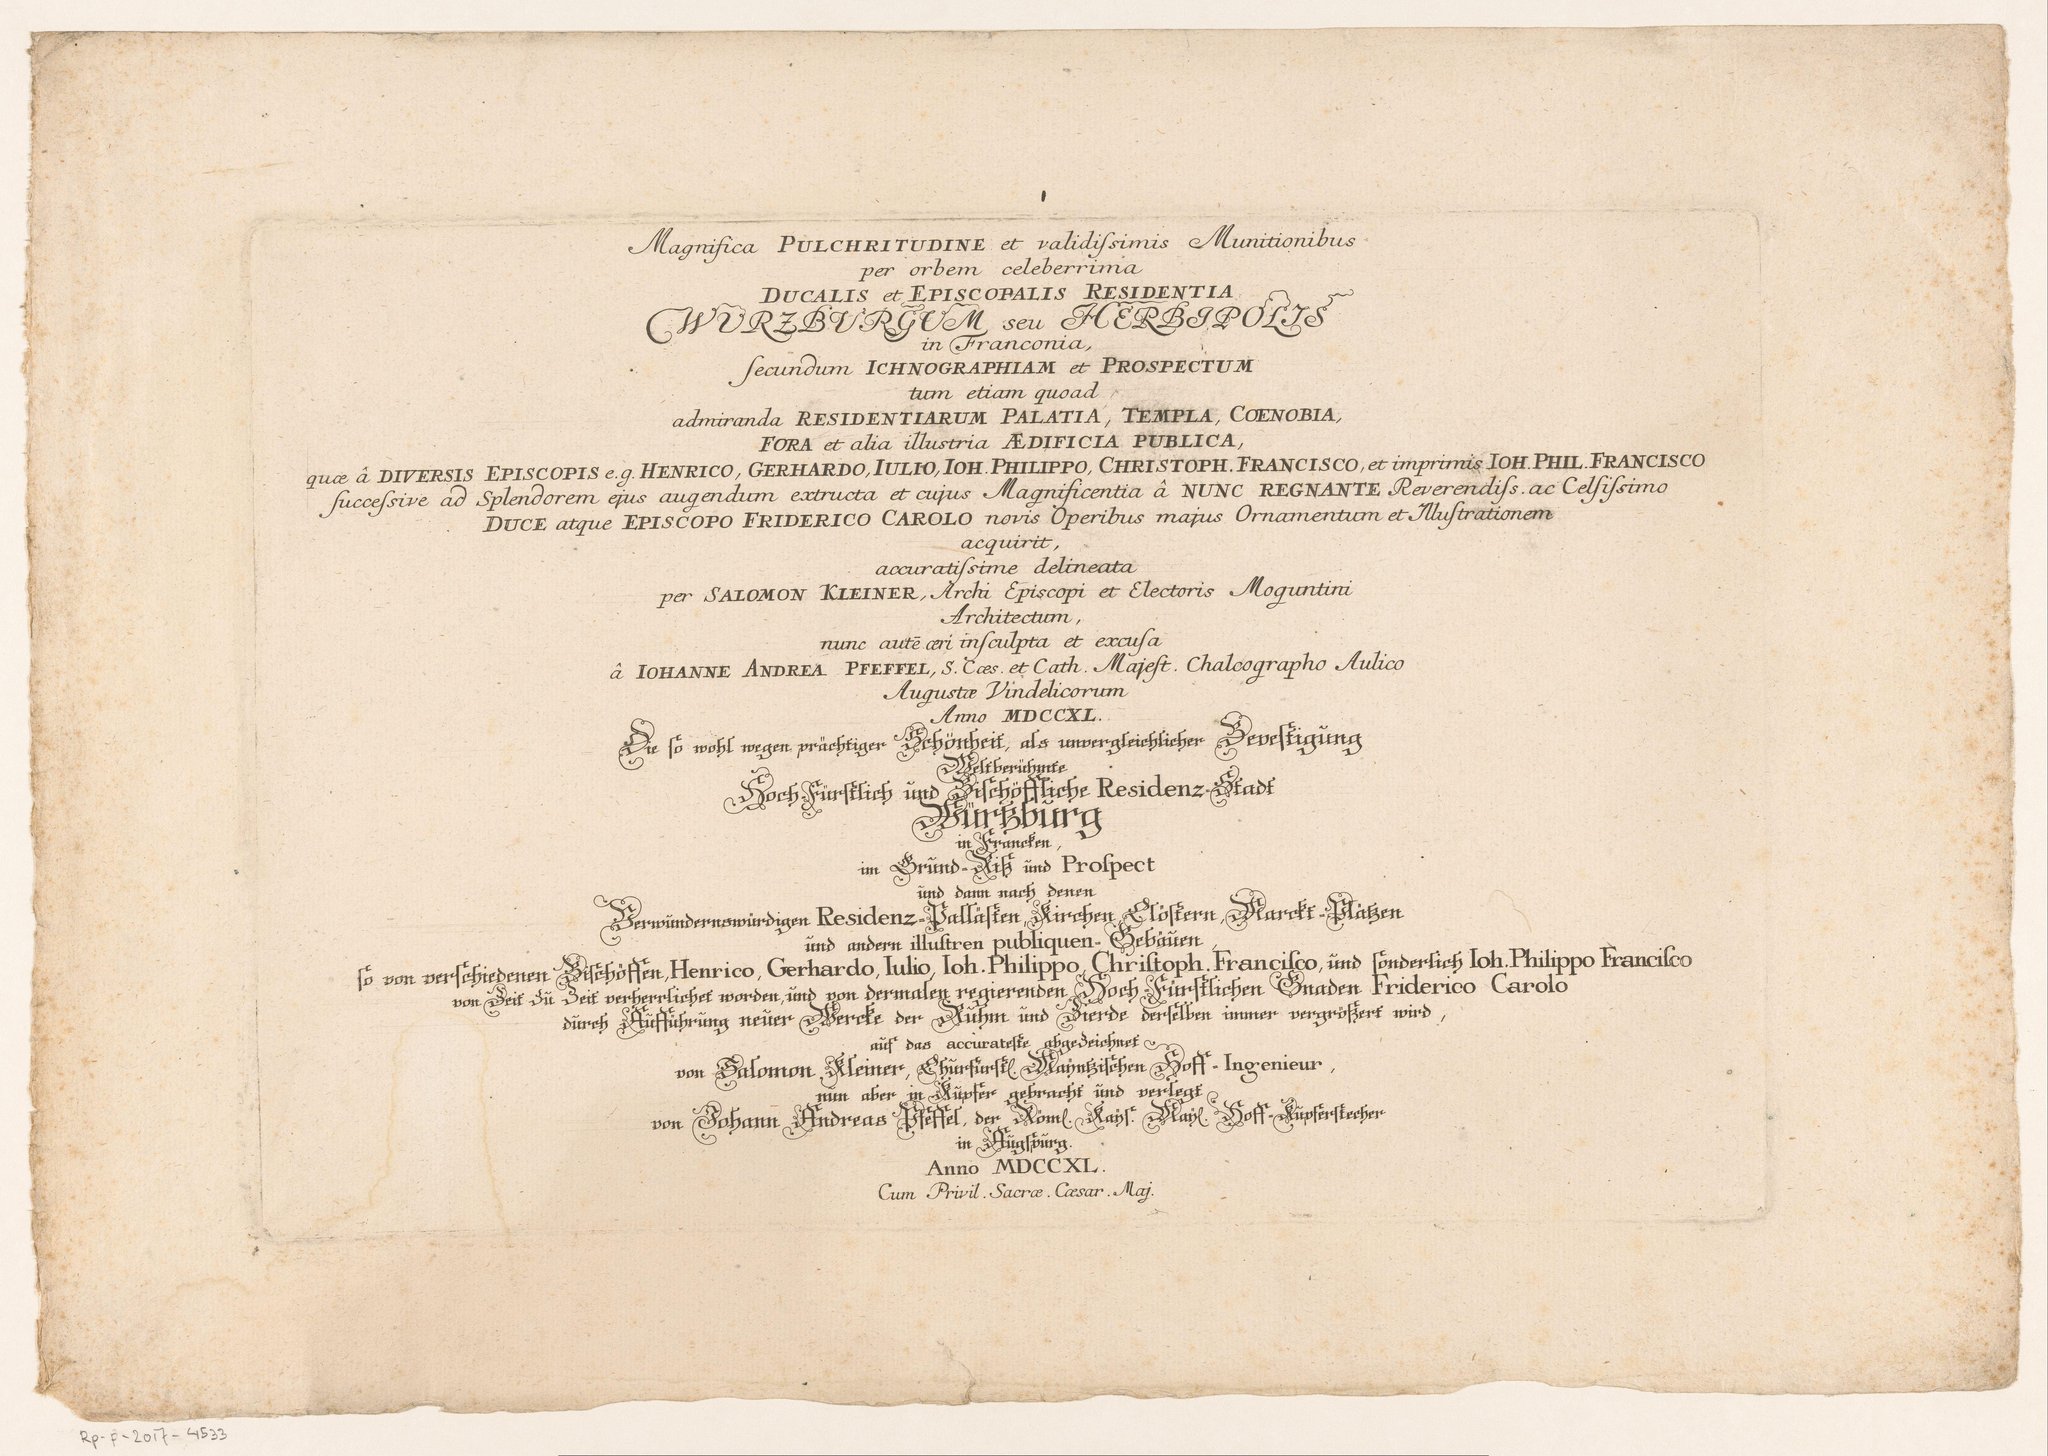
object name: titelprent, frontispice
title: Titelprent van een serie stadsgezichten van Würzburg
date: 1740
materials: paper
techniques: etching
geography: augsburg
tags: city-view, and landscape with man-made constructions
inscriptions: collector's mark: Lugt 2228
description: Serie bestaande uit elf prenten plus een titelprent.